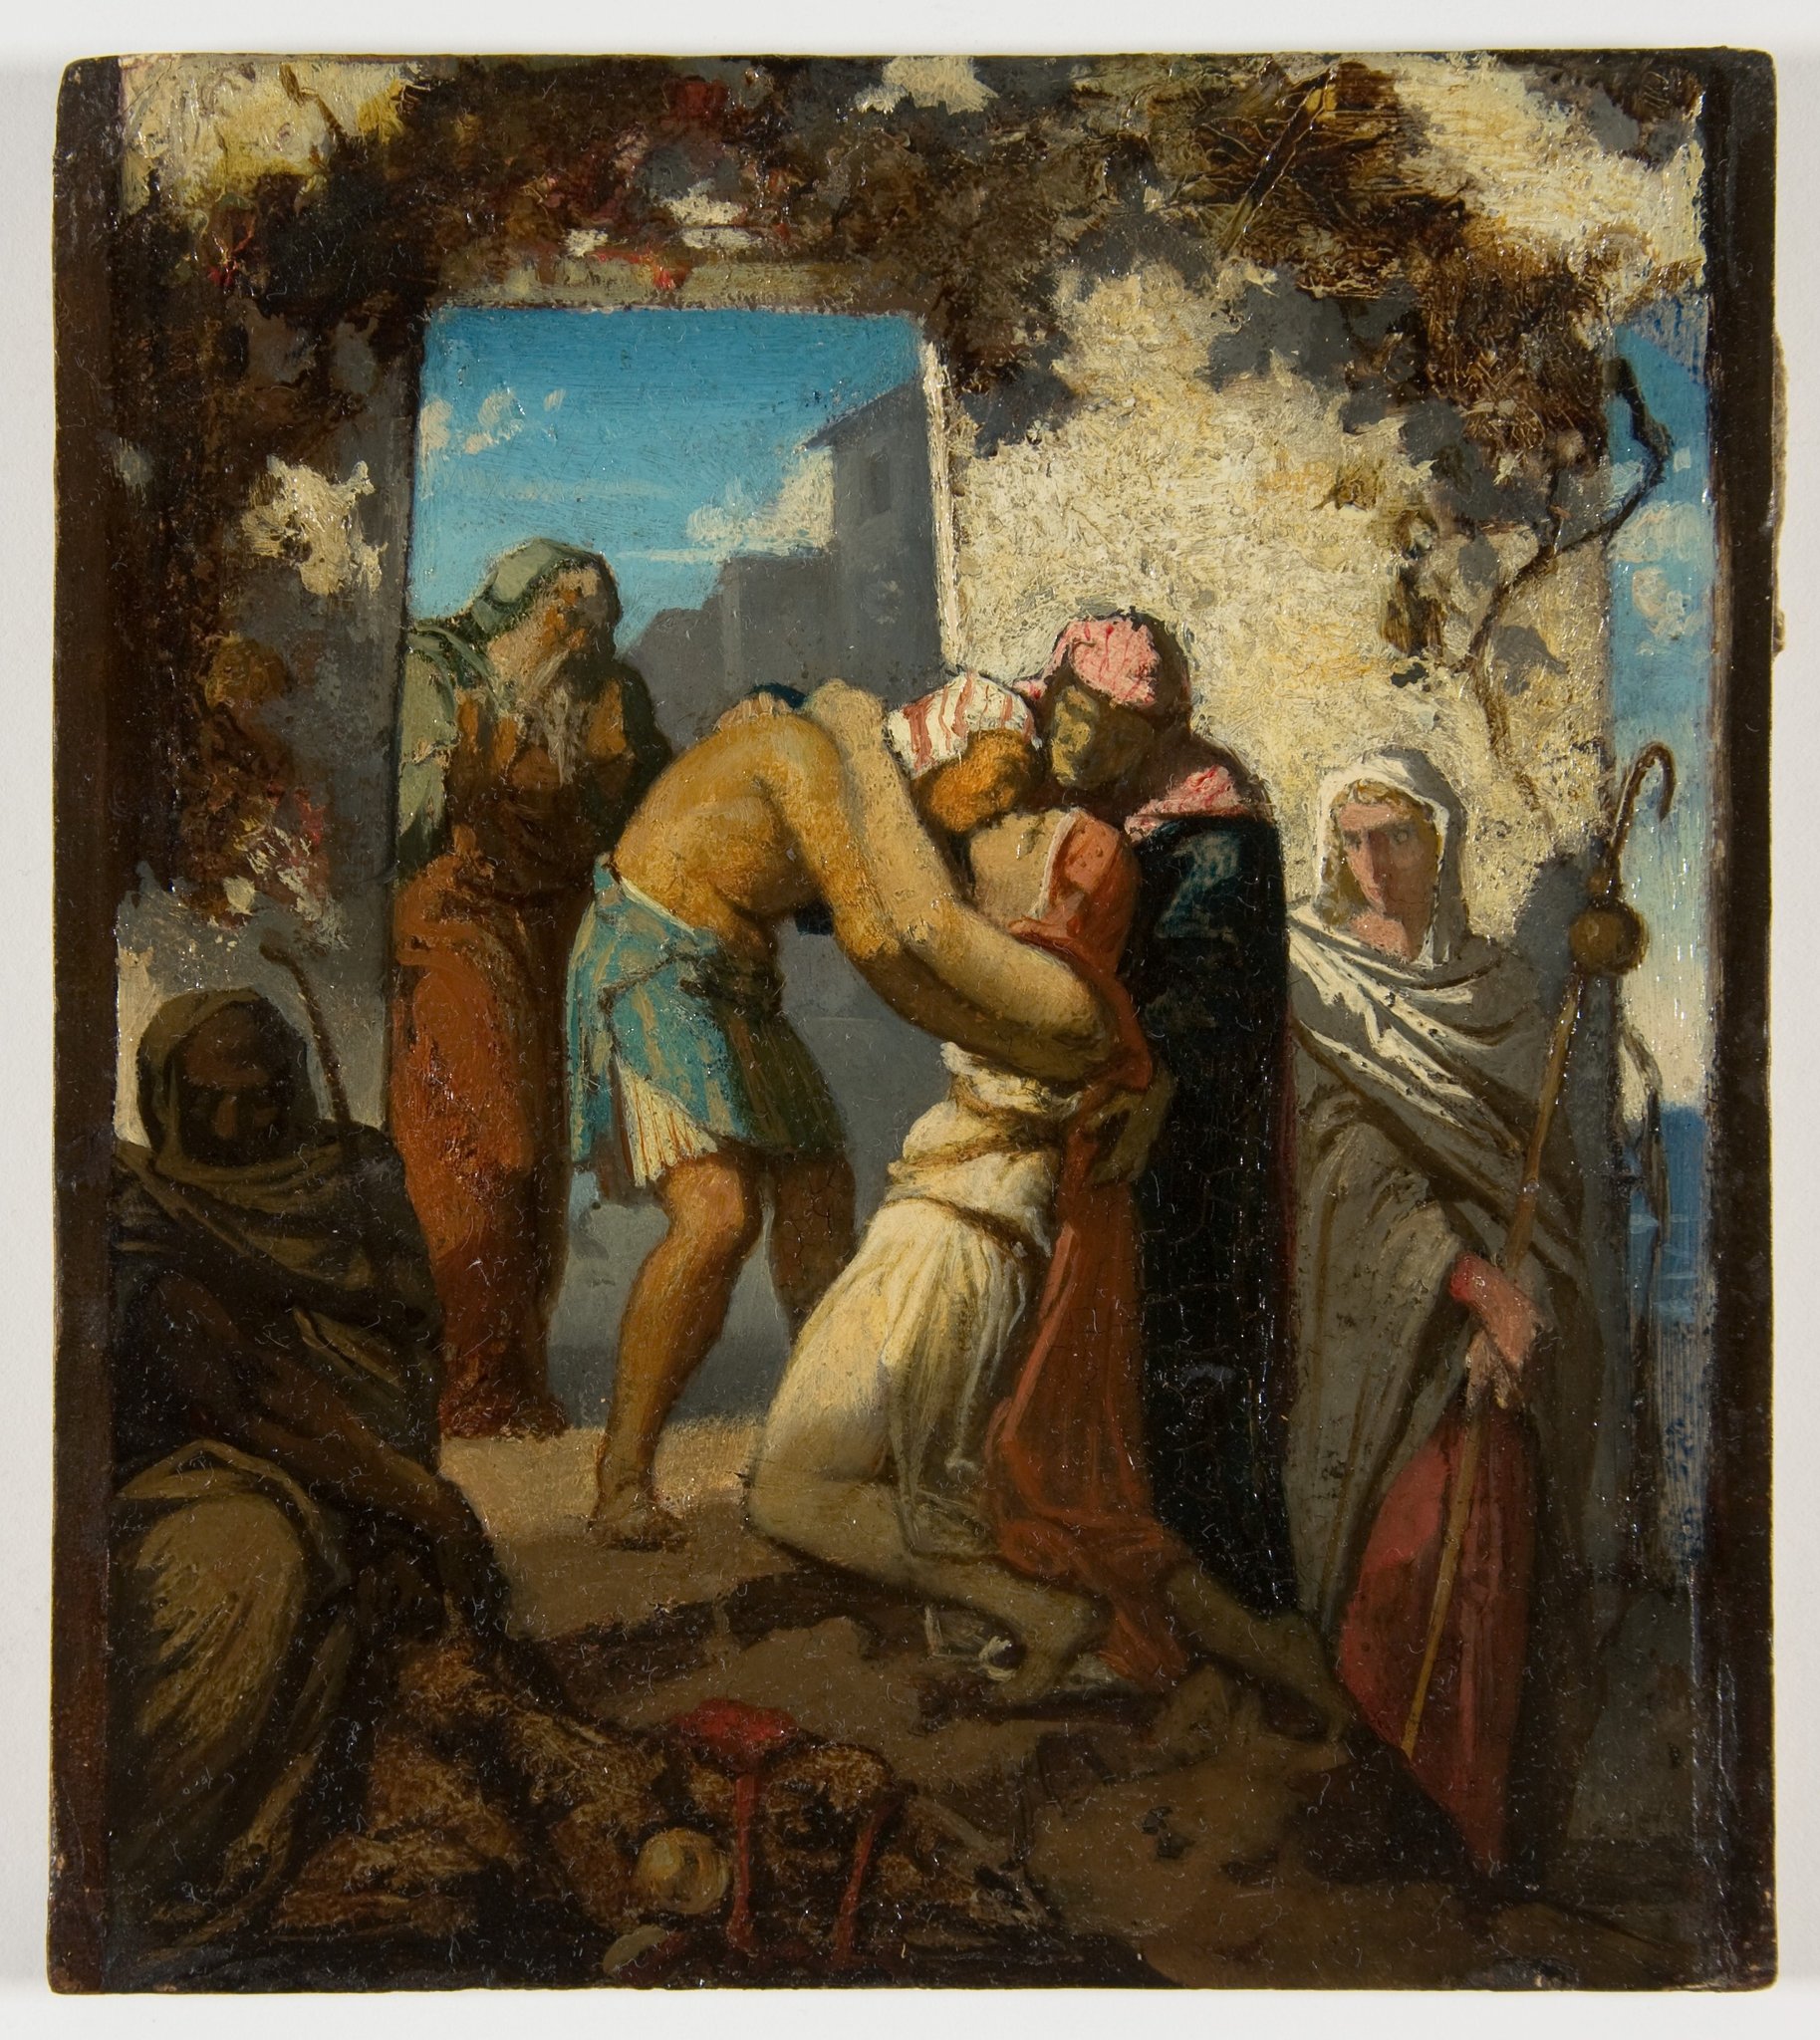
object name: drawing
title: A Scene from the Story of Tobit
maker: henri lehmann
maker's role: artist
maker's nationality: french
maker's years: 1814-1882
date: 1834-1882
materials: cardboard, oil, paper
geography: france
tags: men,women